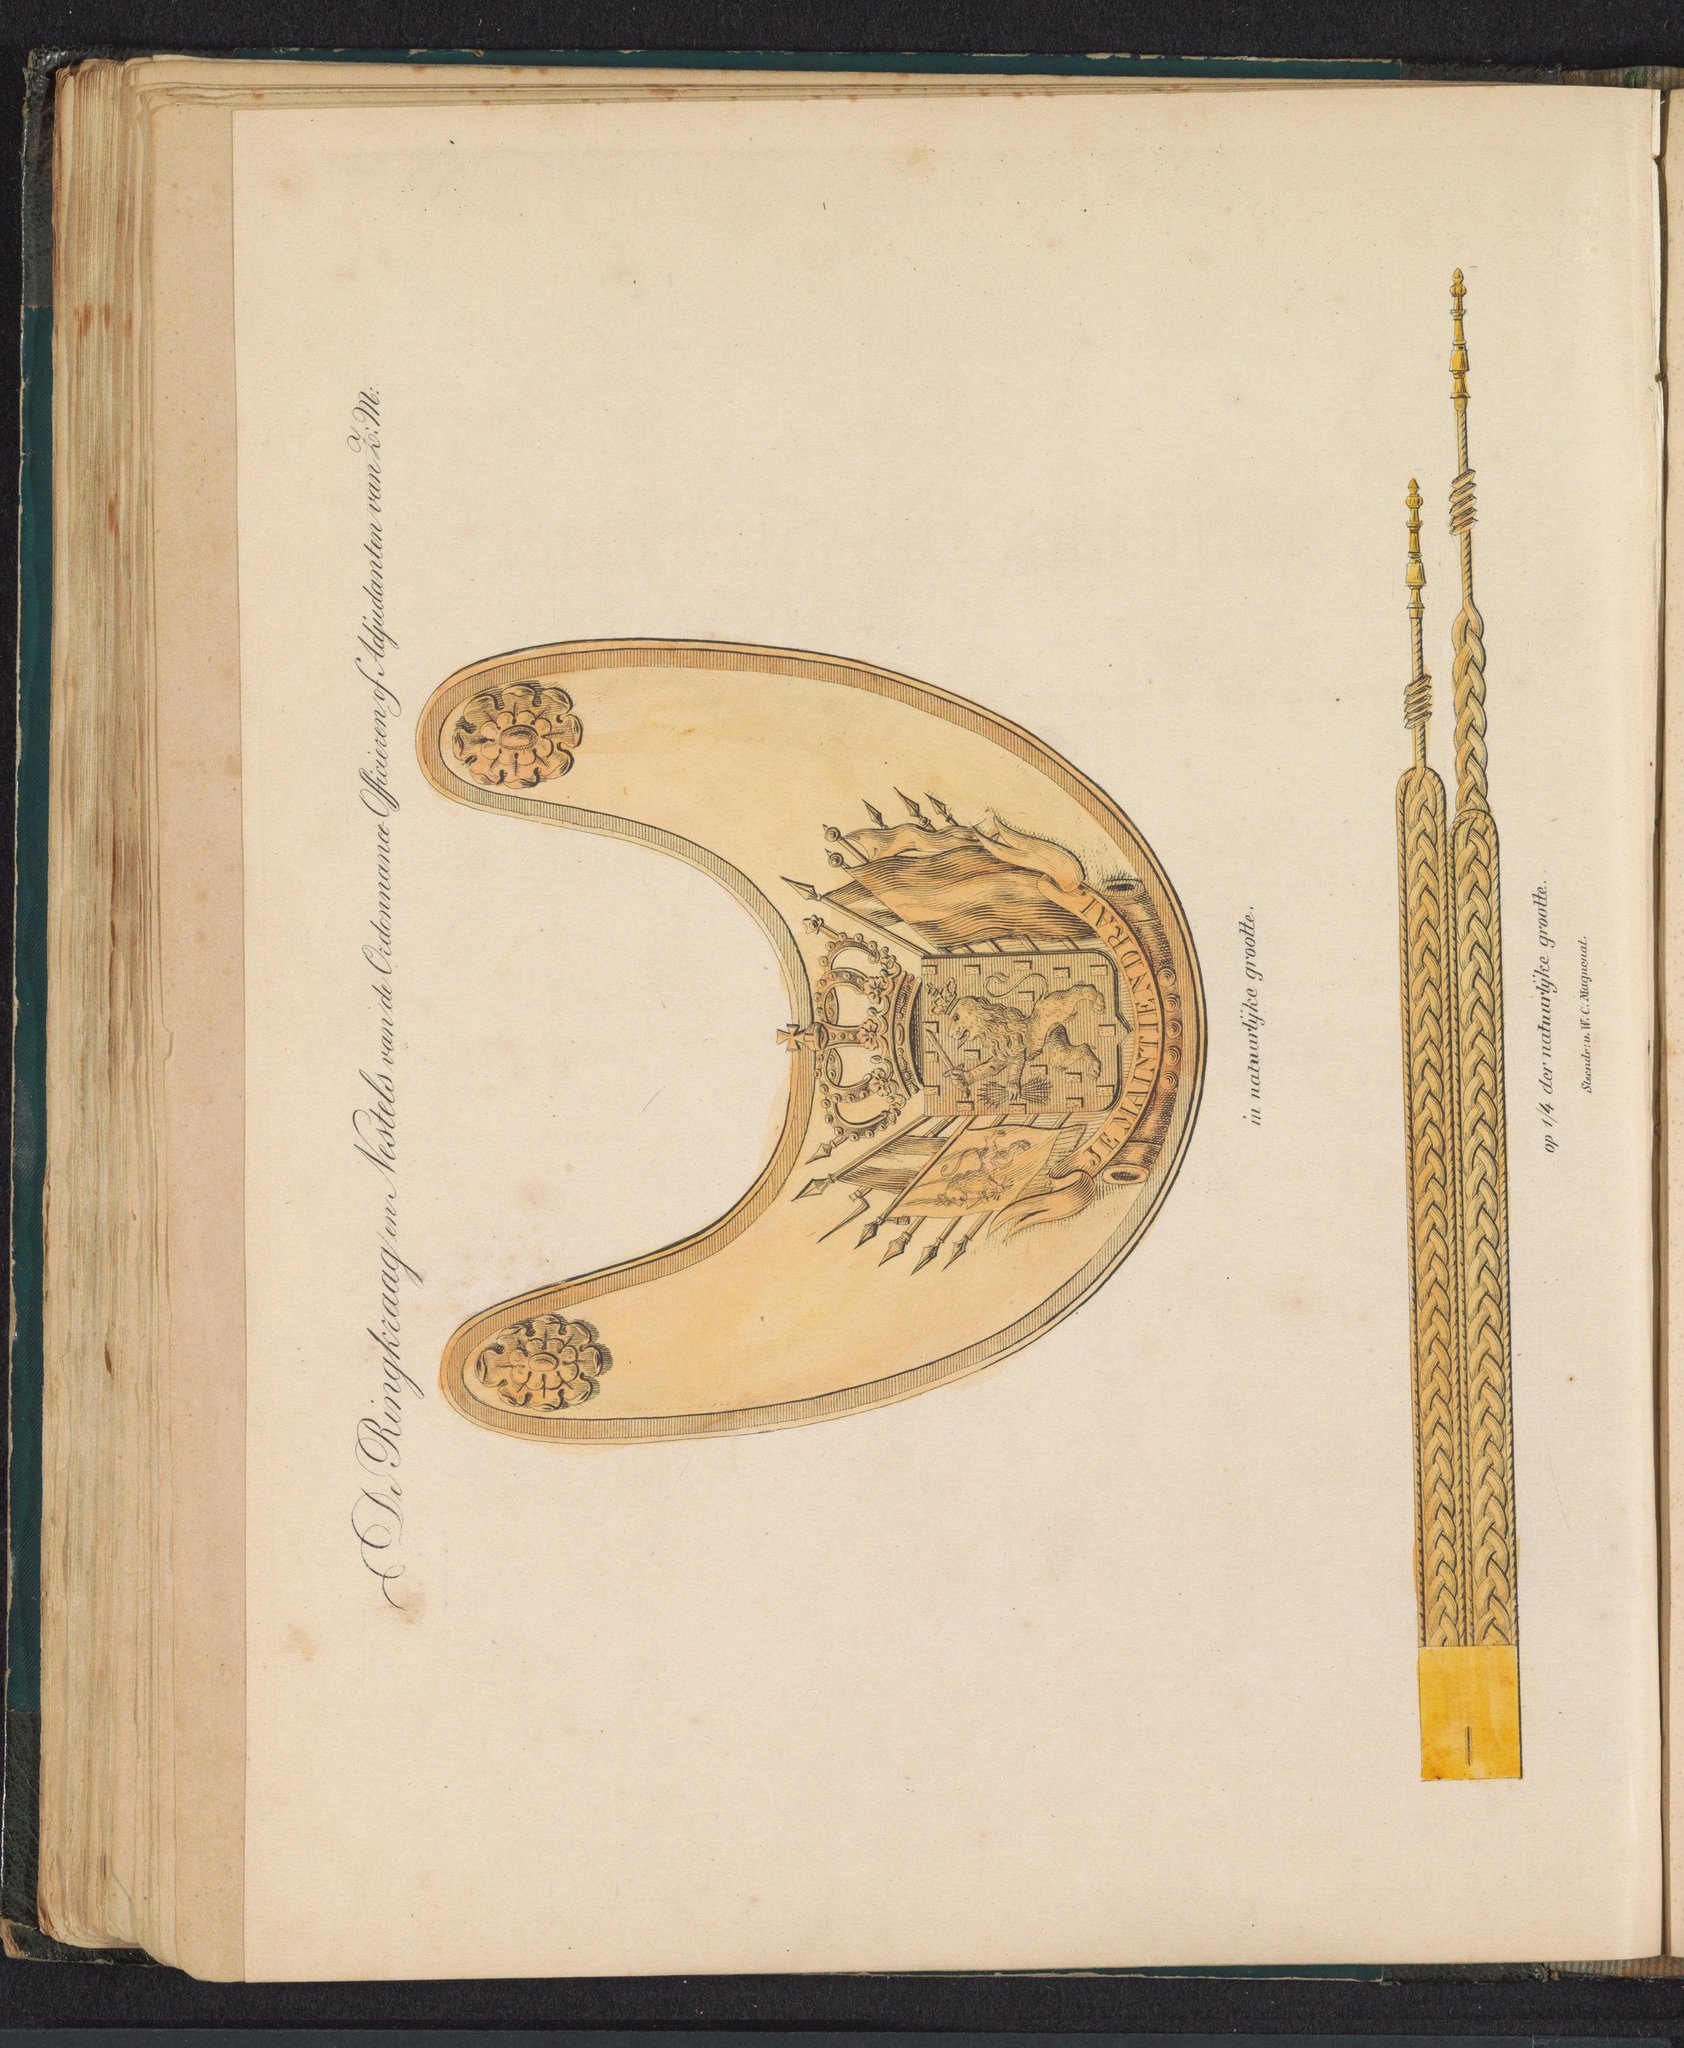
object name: print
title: Ringkraag en nestels voor de ordonnace officieren en adjudanten van de koning, 1845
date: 1845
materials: paper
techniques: hand coloring, lithograph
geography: amsterdam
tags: (military) uniforms, netherlands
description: Ringkraag en nestels voor de ordonnace officieren en adjudanten van de koning. Illustratie in een boek uit 1845 over de uniformen en kledingstukken van de Nederlandse land-, zeemacht en schutterijen in Nederland en in de overzeese gebiedsdelen.